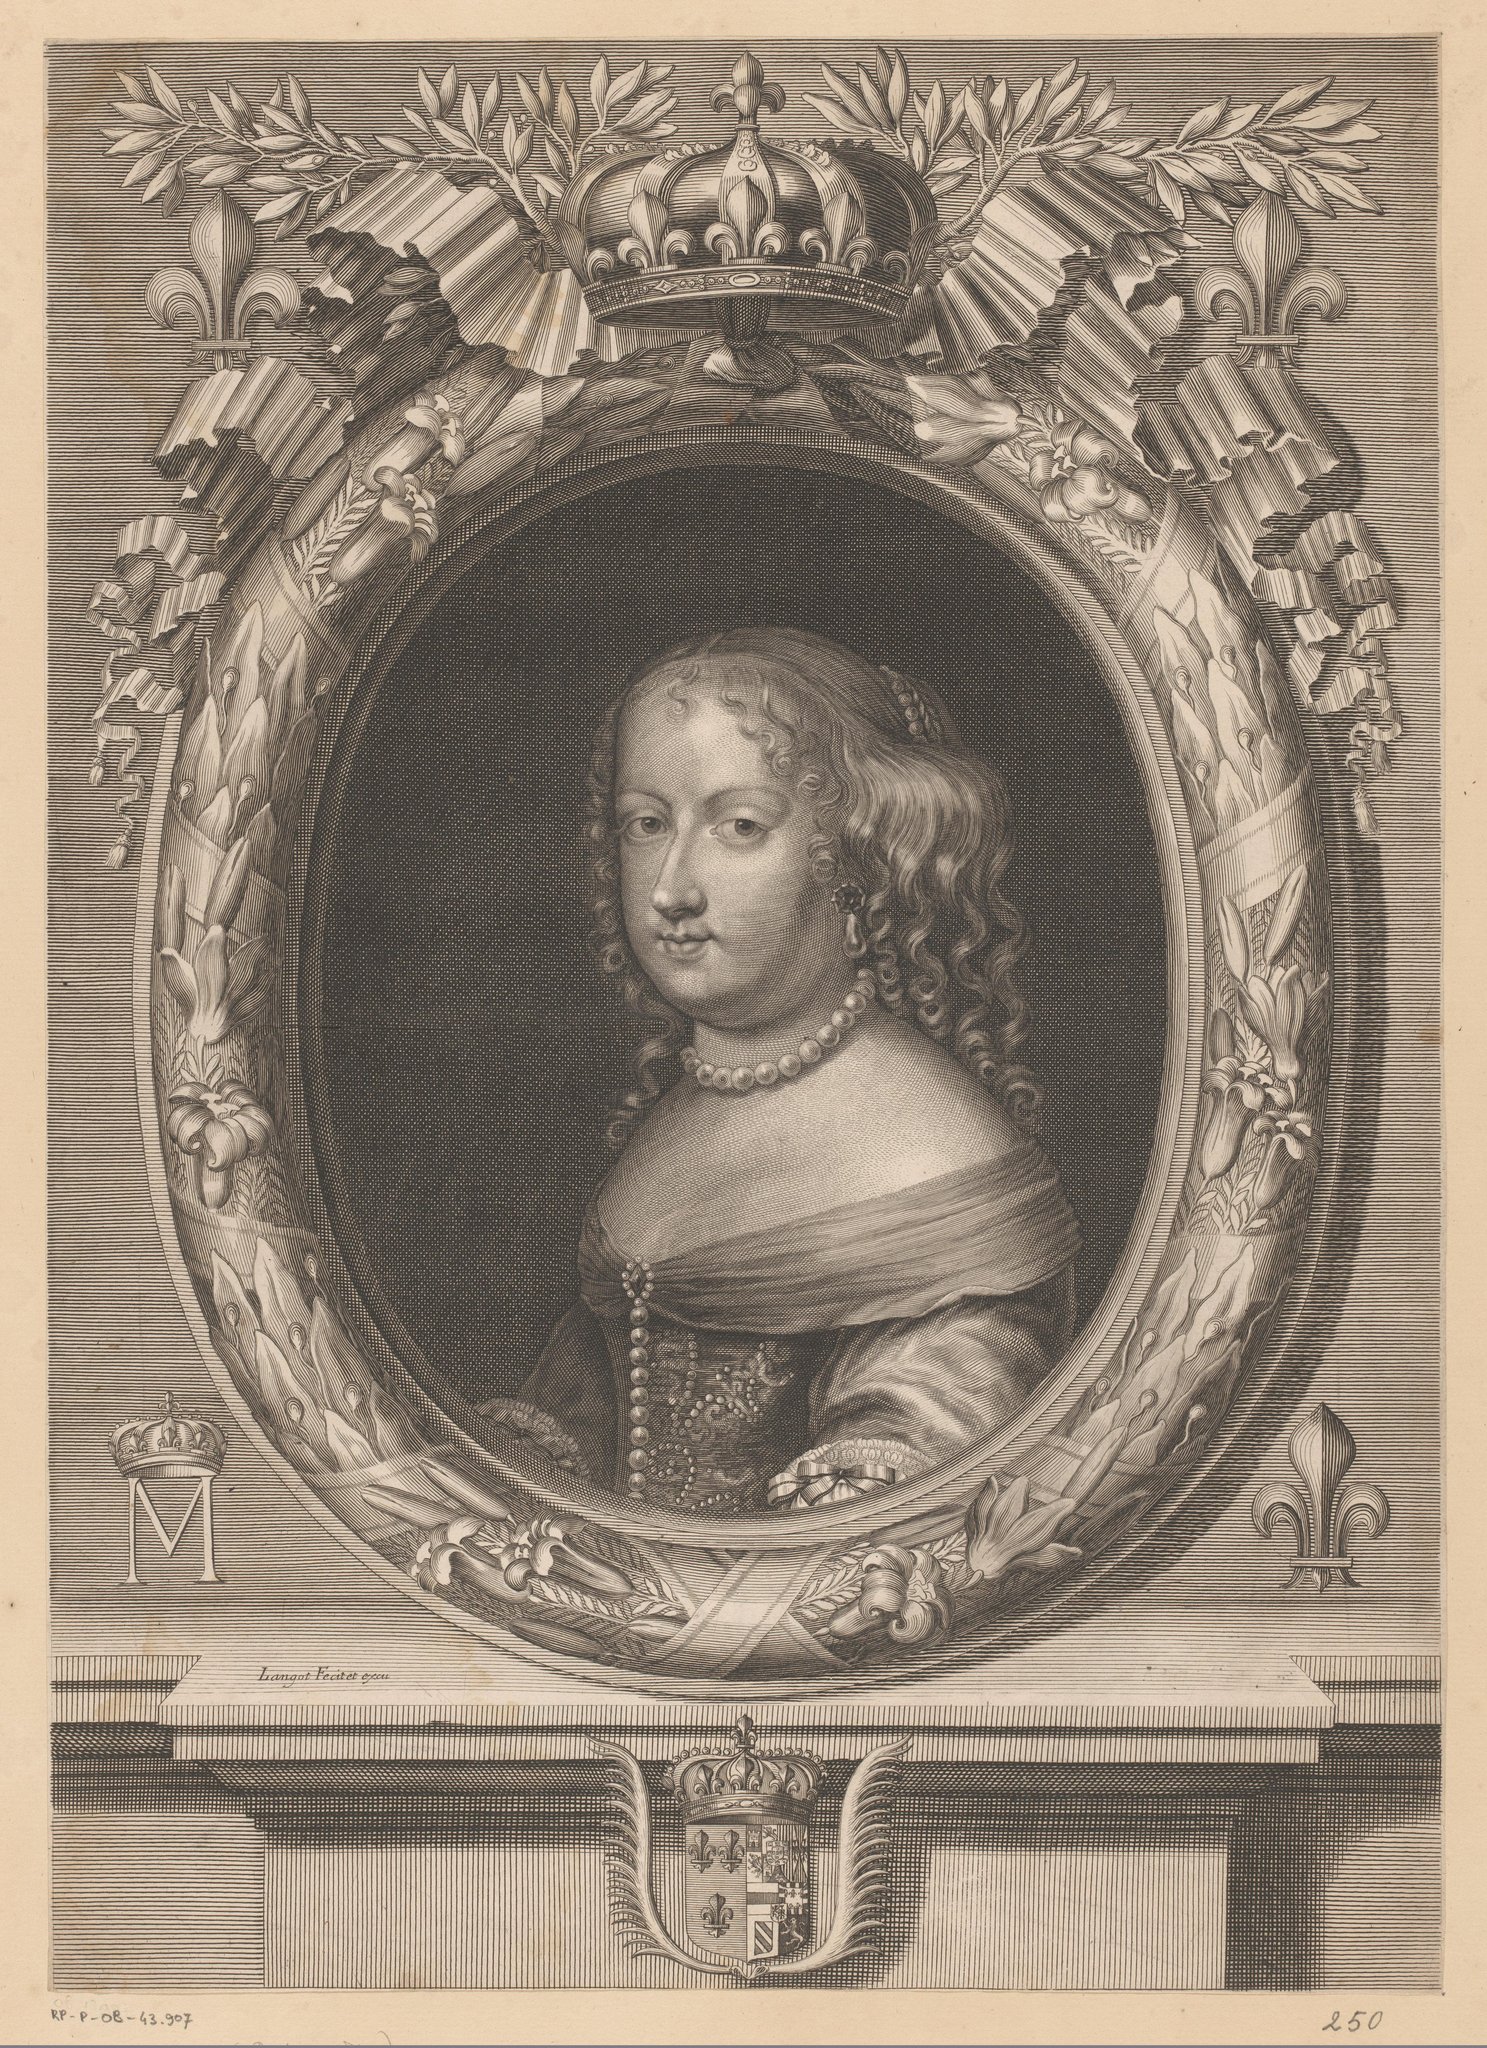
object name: print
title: Portret van een onbekende jonge vrouw, waarschijnlijk een prinses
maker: françois langot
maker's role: print maker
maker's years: -1679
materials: paper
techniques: engraving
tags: fleur-de-lis ~ ornament, historical persons, princess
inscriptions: collector's mark: Lugt 240